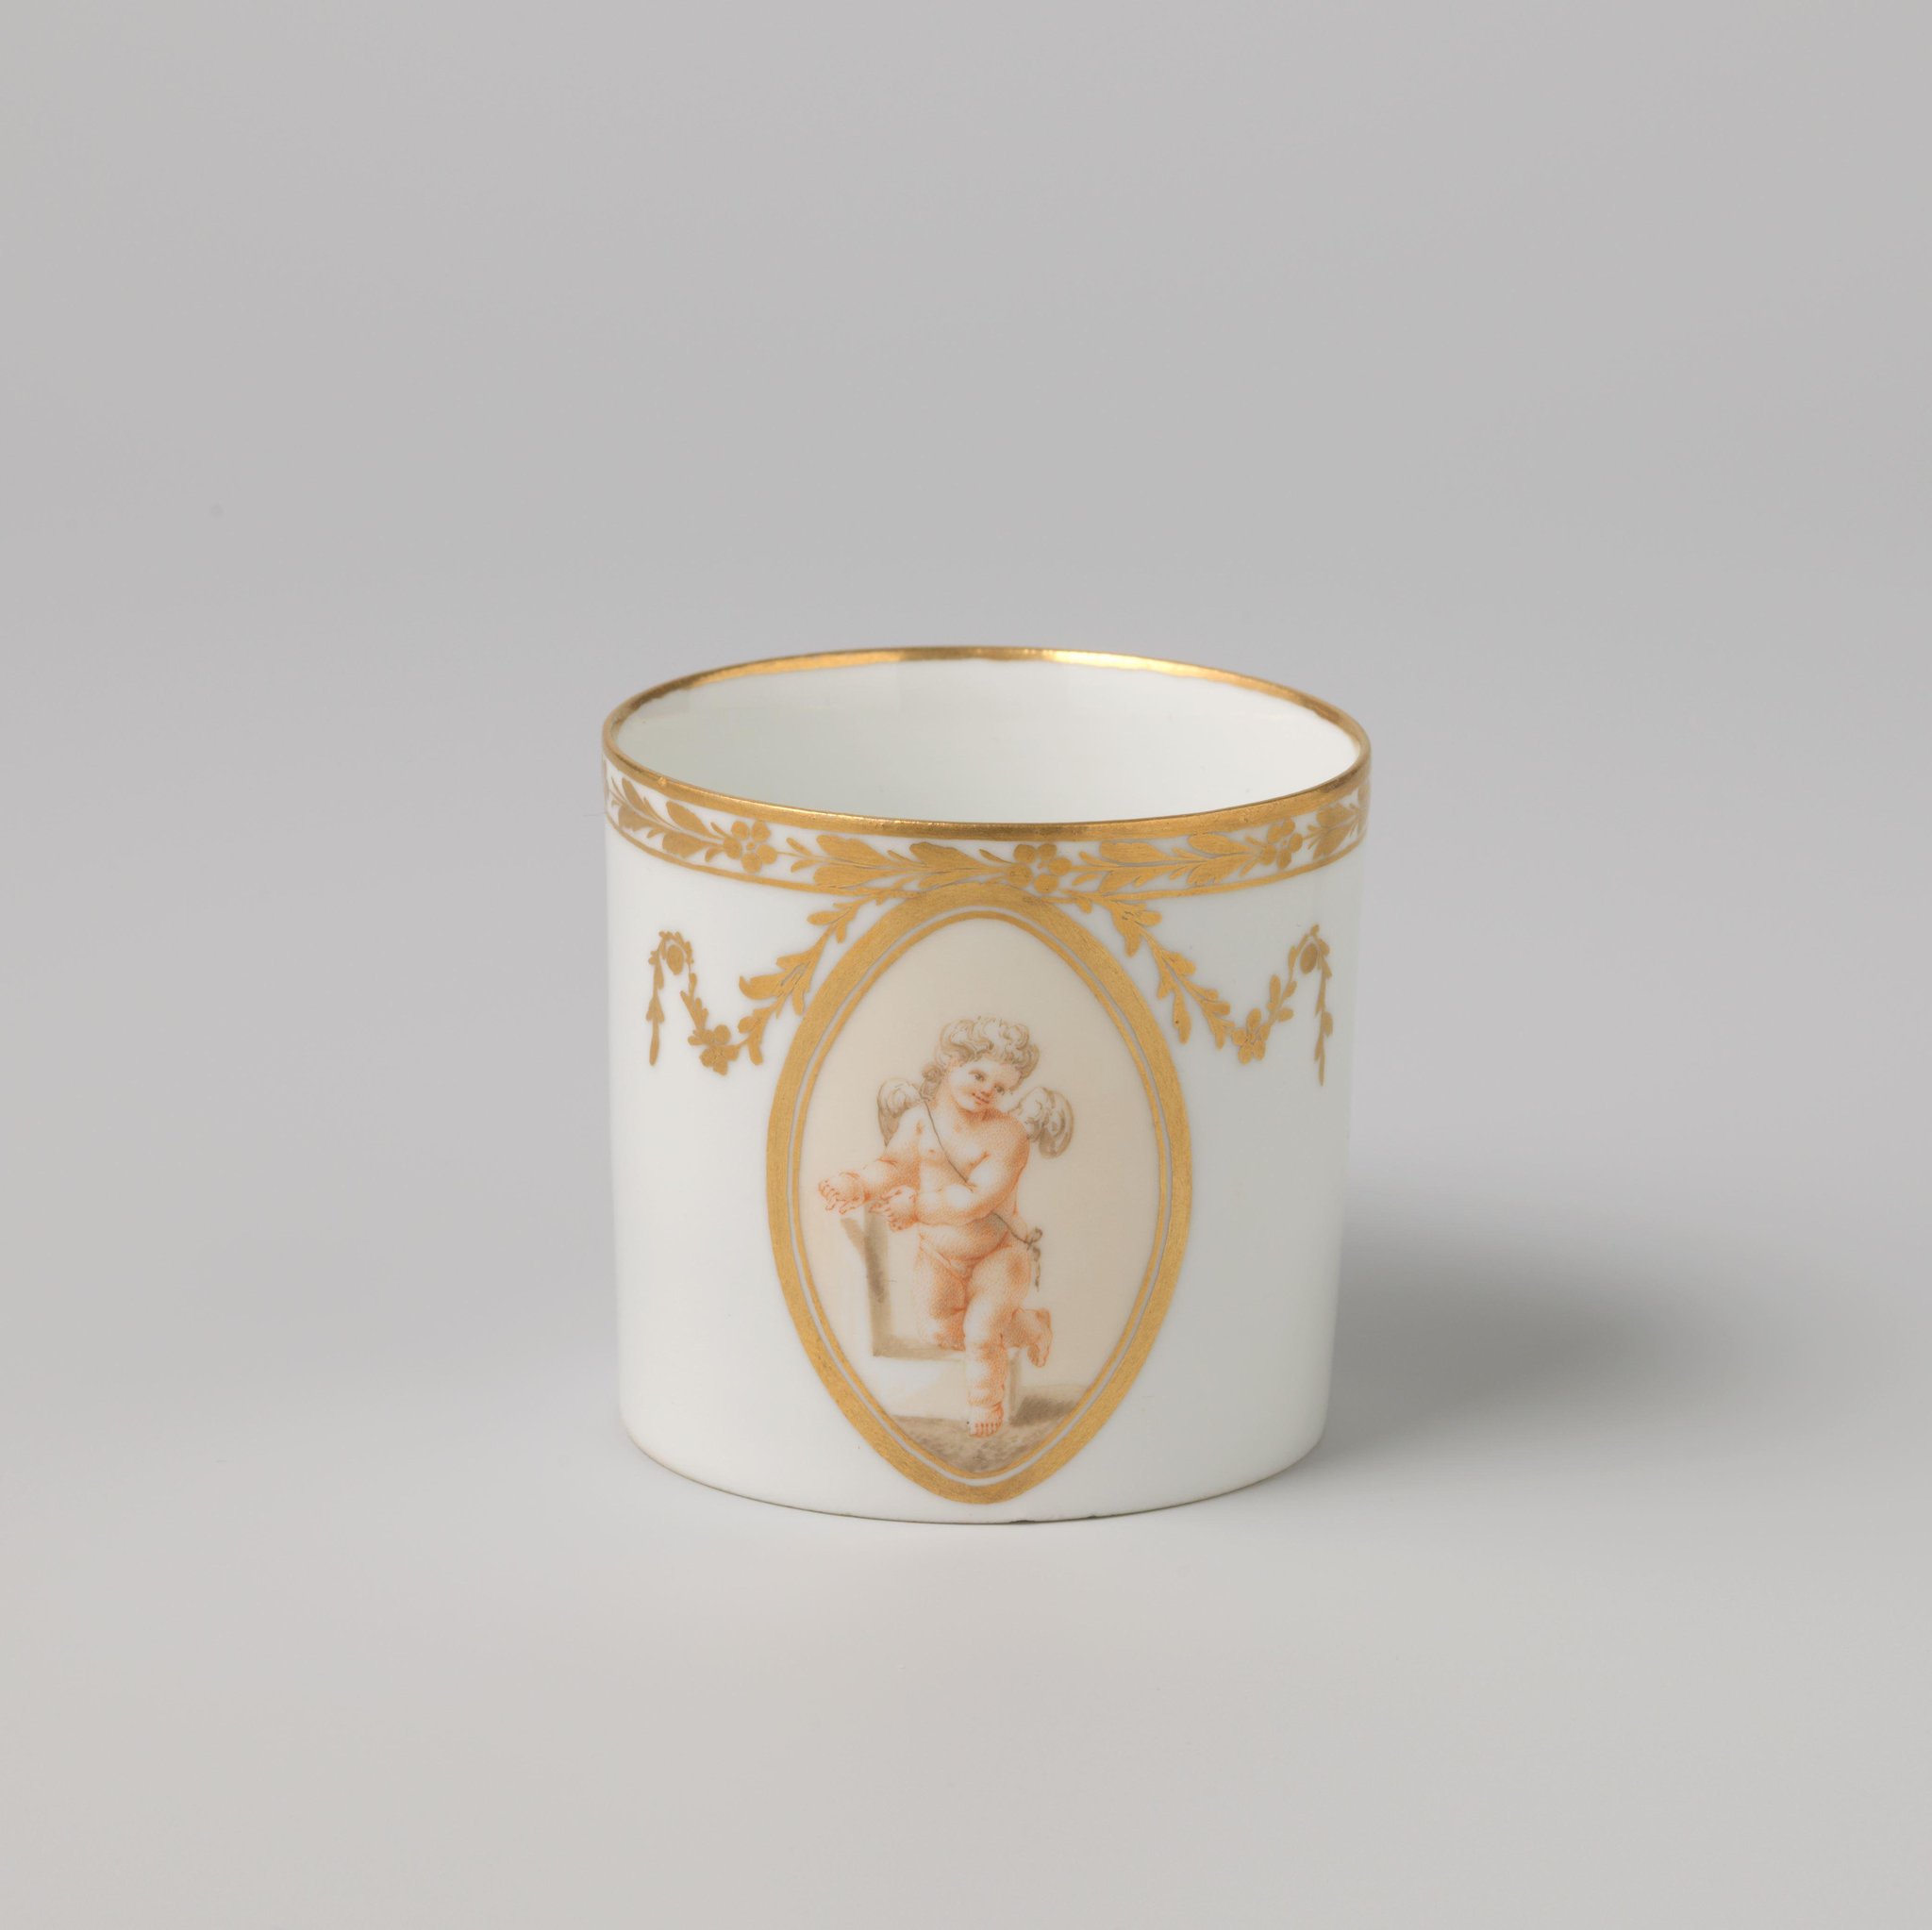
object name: cup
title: Cup with a putto in a medallion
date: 1785-1795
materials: glaze, gold, paint, porcelain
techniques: firing, forming, gilding, turning, vitrification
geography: furstenberg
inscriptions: mark: ‘F/ 10/ 10N’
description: Kop van porselein met een cilindrische wand en hoekig oor, beschilderd op het glazuur in sepia en goud. Op de buitenwand een medaillon met een putto leunend op een L-vormig blok. Boven het medaillon een guirlande en op de rand een band met een bladrank. Het oor met stippen en bloemmotieven. Gemerkt op de onderzijde met de F, 10 en 10N.